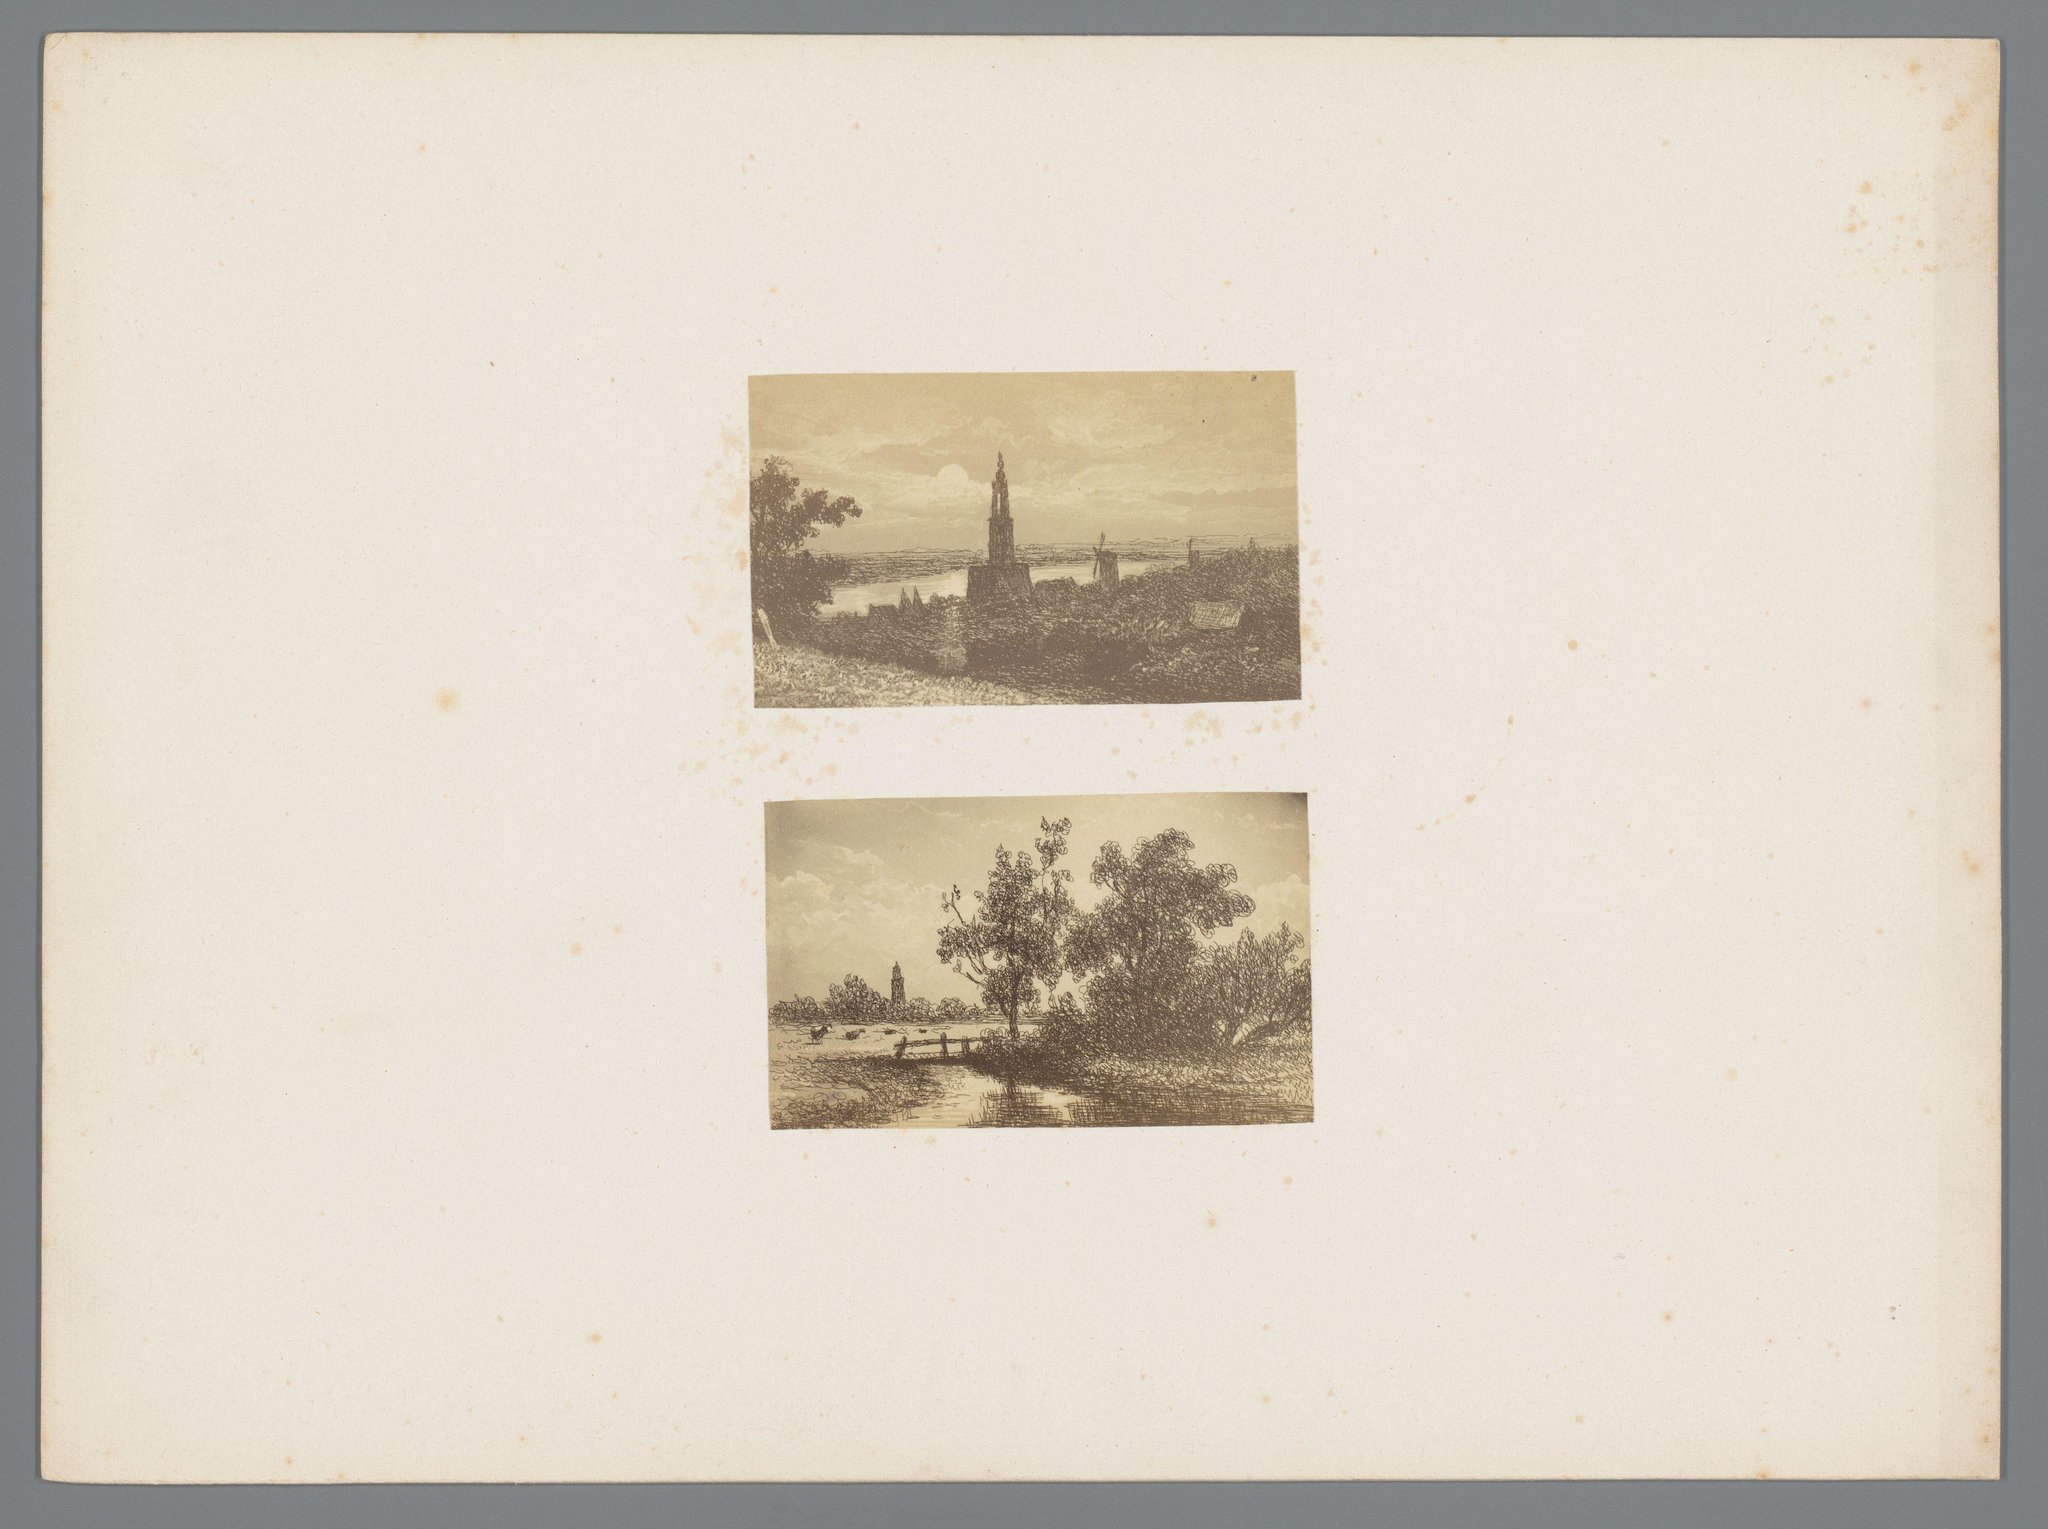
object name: photograph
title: Fotoreproductie van een prent van een landschap met een stad aan een rivier naar Johannes Pieter van Wisselingh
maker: Anonymous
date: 1867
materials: cardboard, photographic support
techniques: albumen print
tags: city-view in general; 'veduta', river, parts of church exterior and annexes: tower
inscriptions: collector's mark: Lugt 2233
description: Deze foto maakt deel uit van een omslag met 7 foto's.